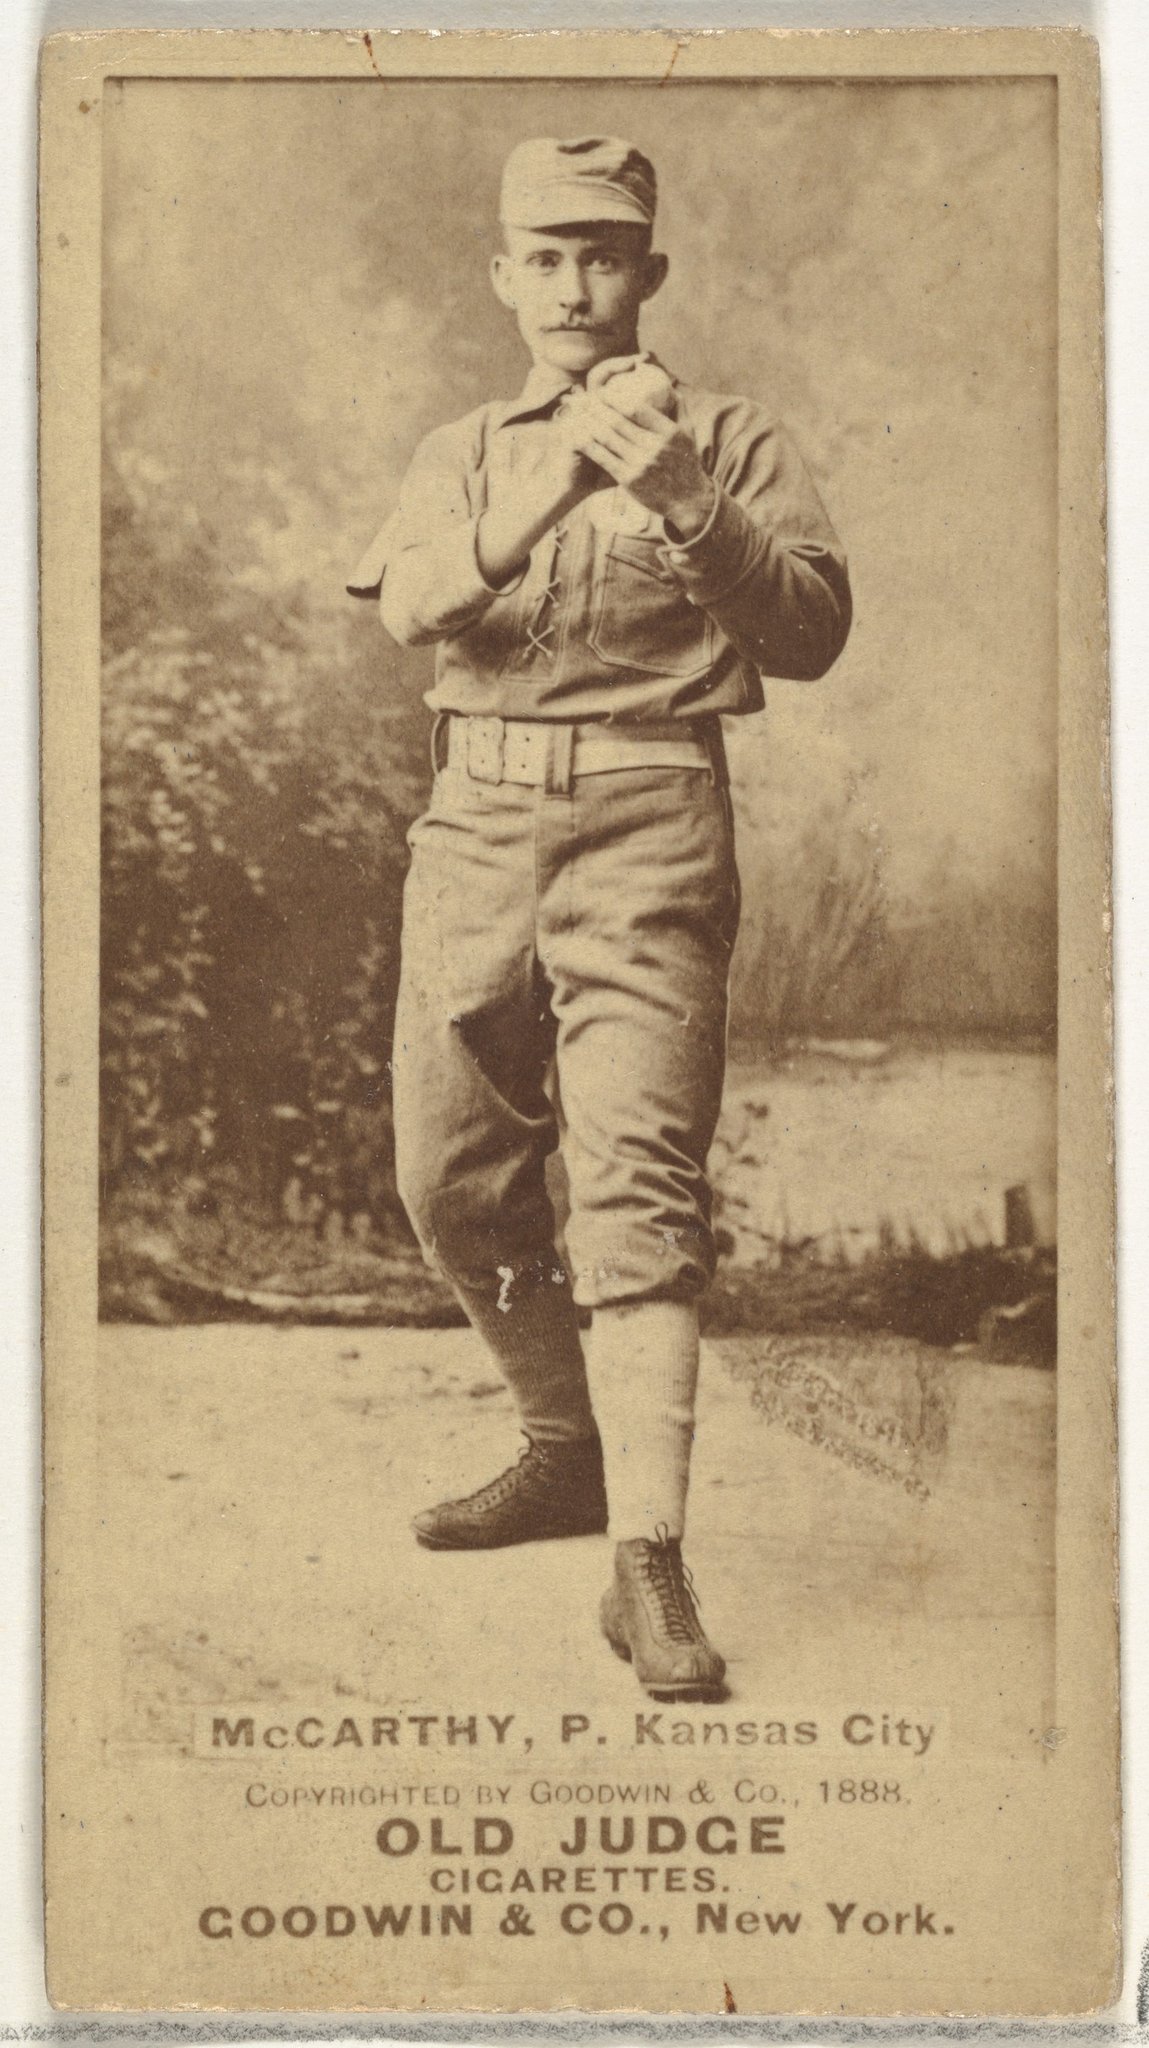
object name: baseball card, photograph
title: John A. McCarty, Pitcher, Kansas City Cowboys, from the Old Judge series (N172) for Old Judge Cigarettes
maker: goodwin & company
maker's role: publisher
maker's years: 1850-1950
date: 1888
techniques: albumen silver print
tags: men,portraits,baseball,athletes